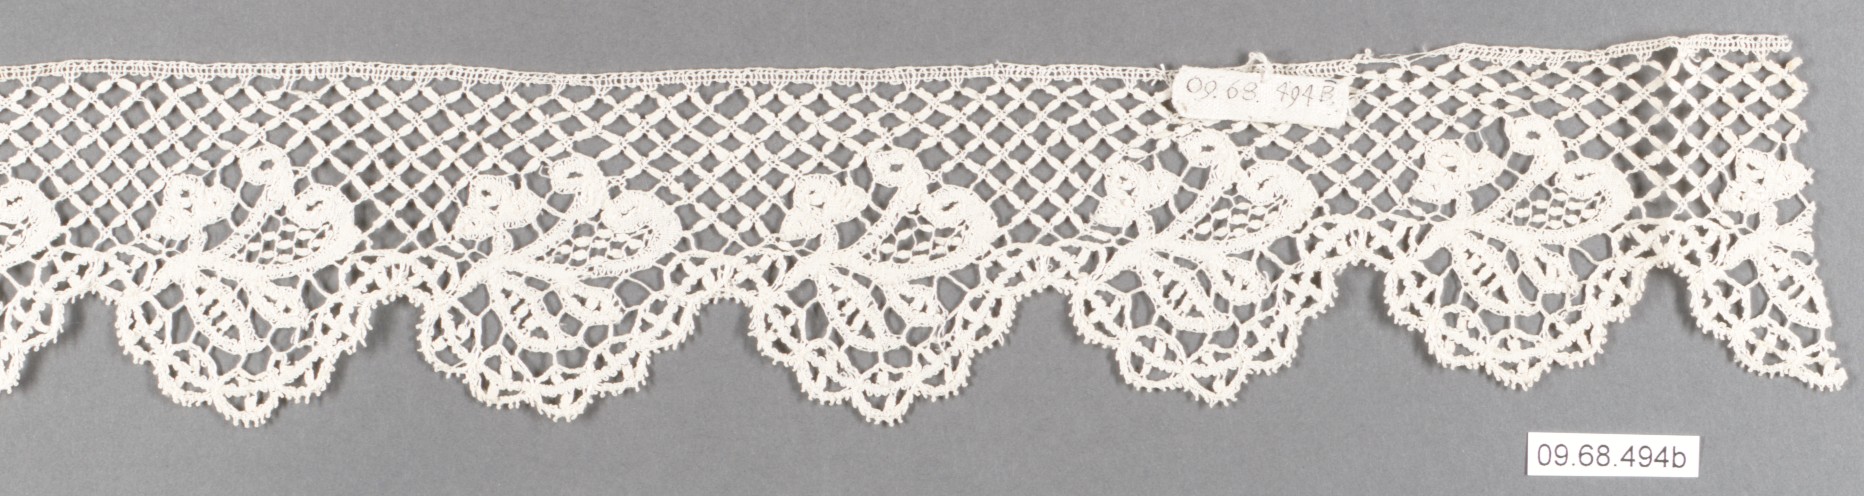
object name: strip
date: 1801-1900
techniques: lace